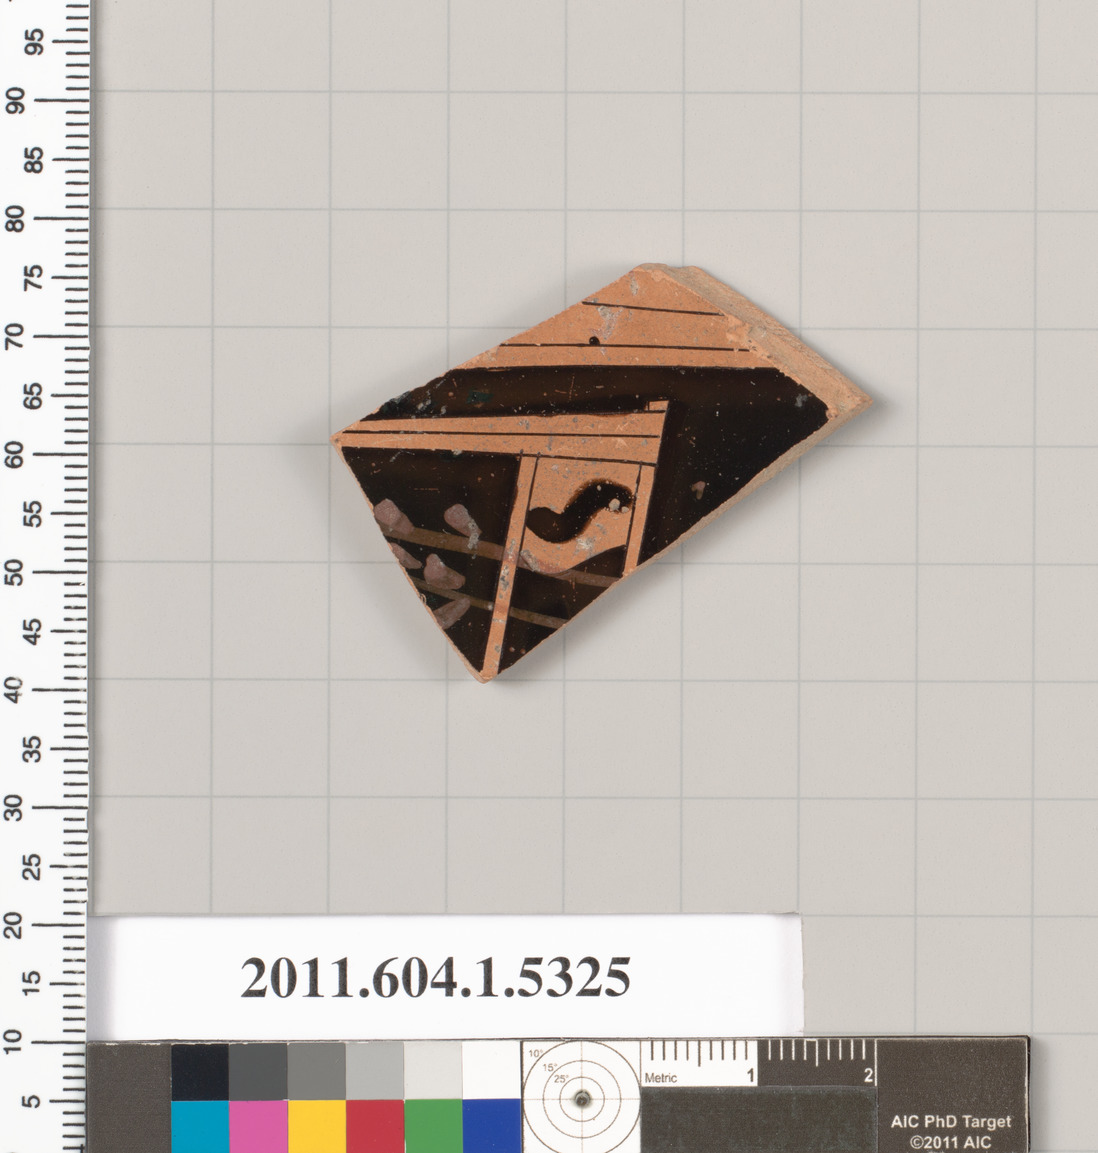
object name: kylix fragment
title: Terracotta fragment of a kylix (drinking cup)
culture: greek, attic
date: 500-480 BCE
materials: terracotta